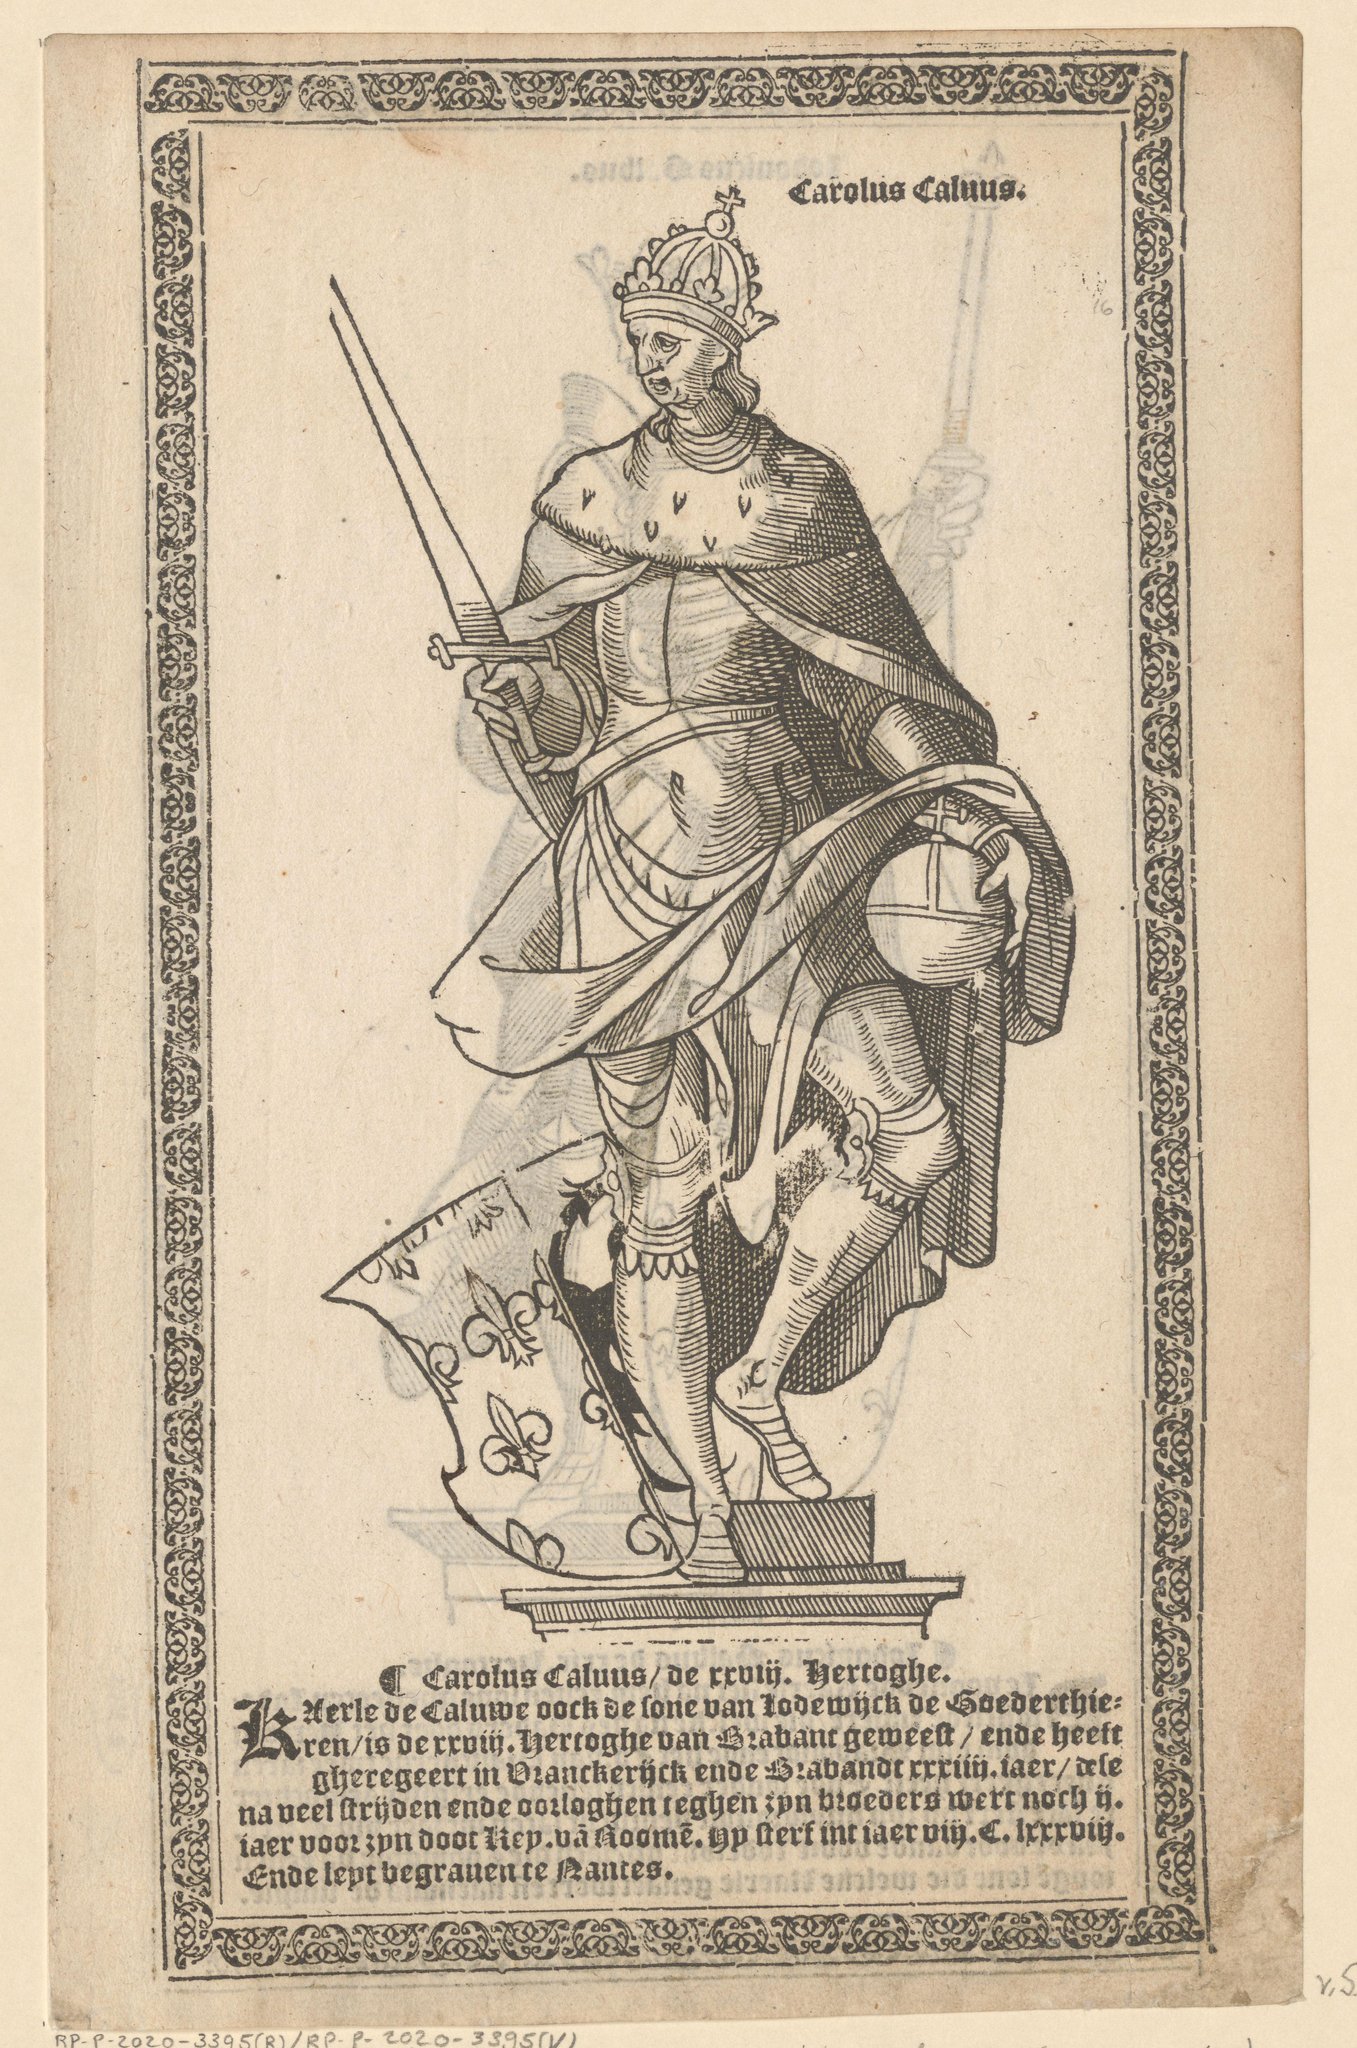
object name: book illustration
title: Portret van keizer Karel de Kale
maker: jan molijns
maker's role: print maker, publisher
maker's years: 1498-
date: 1565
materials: paper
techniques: letterpress printing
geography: antwerp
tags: historical persons, hacking and thrusting weapons: sword, king, armorial bearing, heraldry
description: Prent uit: Dit is die afcoemste ende genalogie der hertoghen ende hertoginnen van Brabandt, (...). Antwerpen: Jan Molijns, 1565.